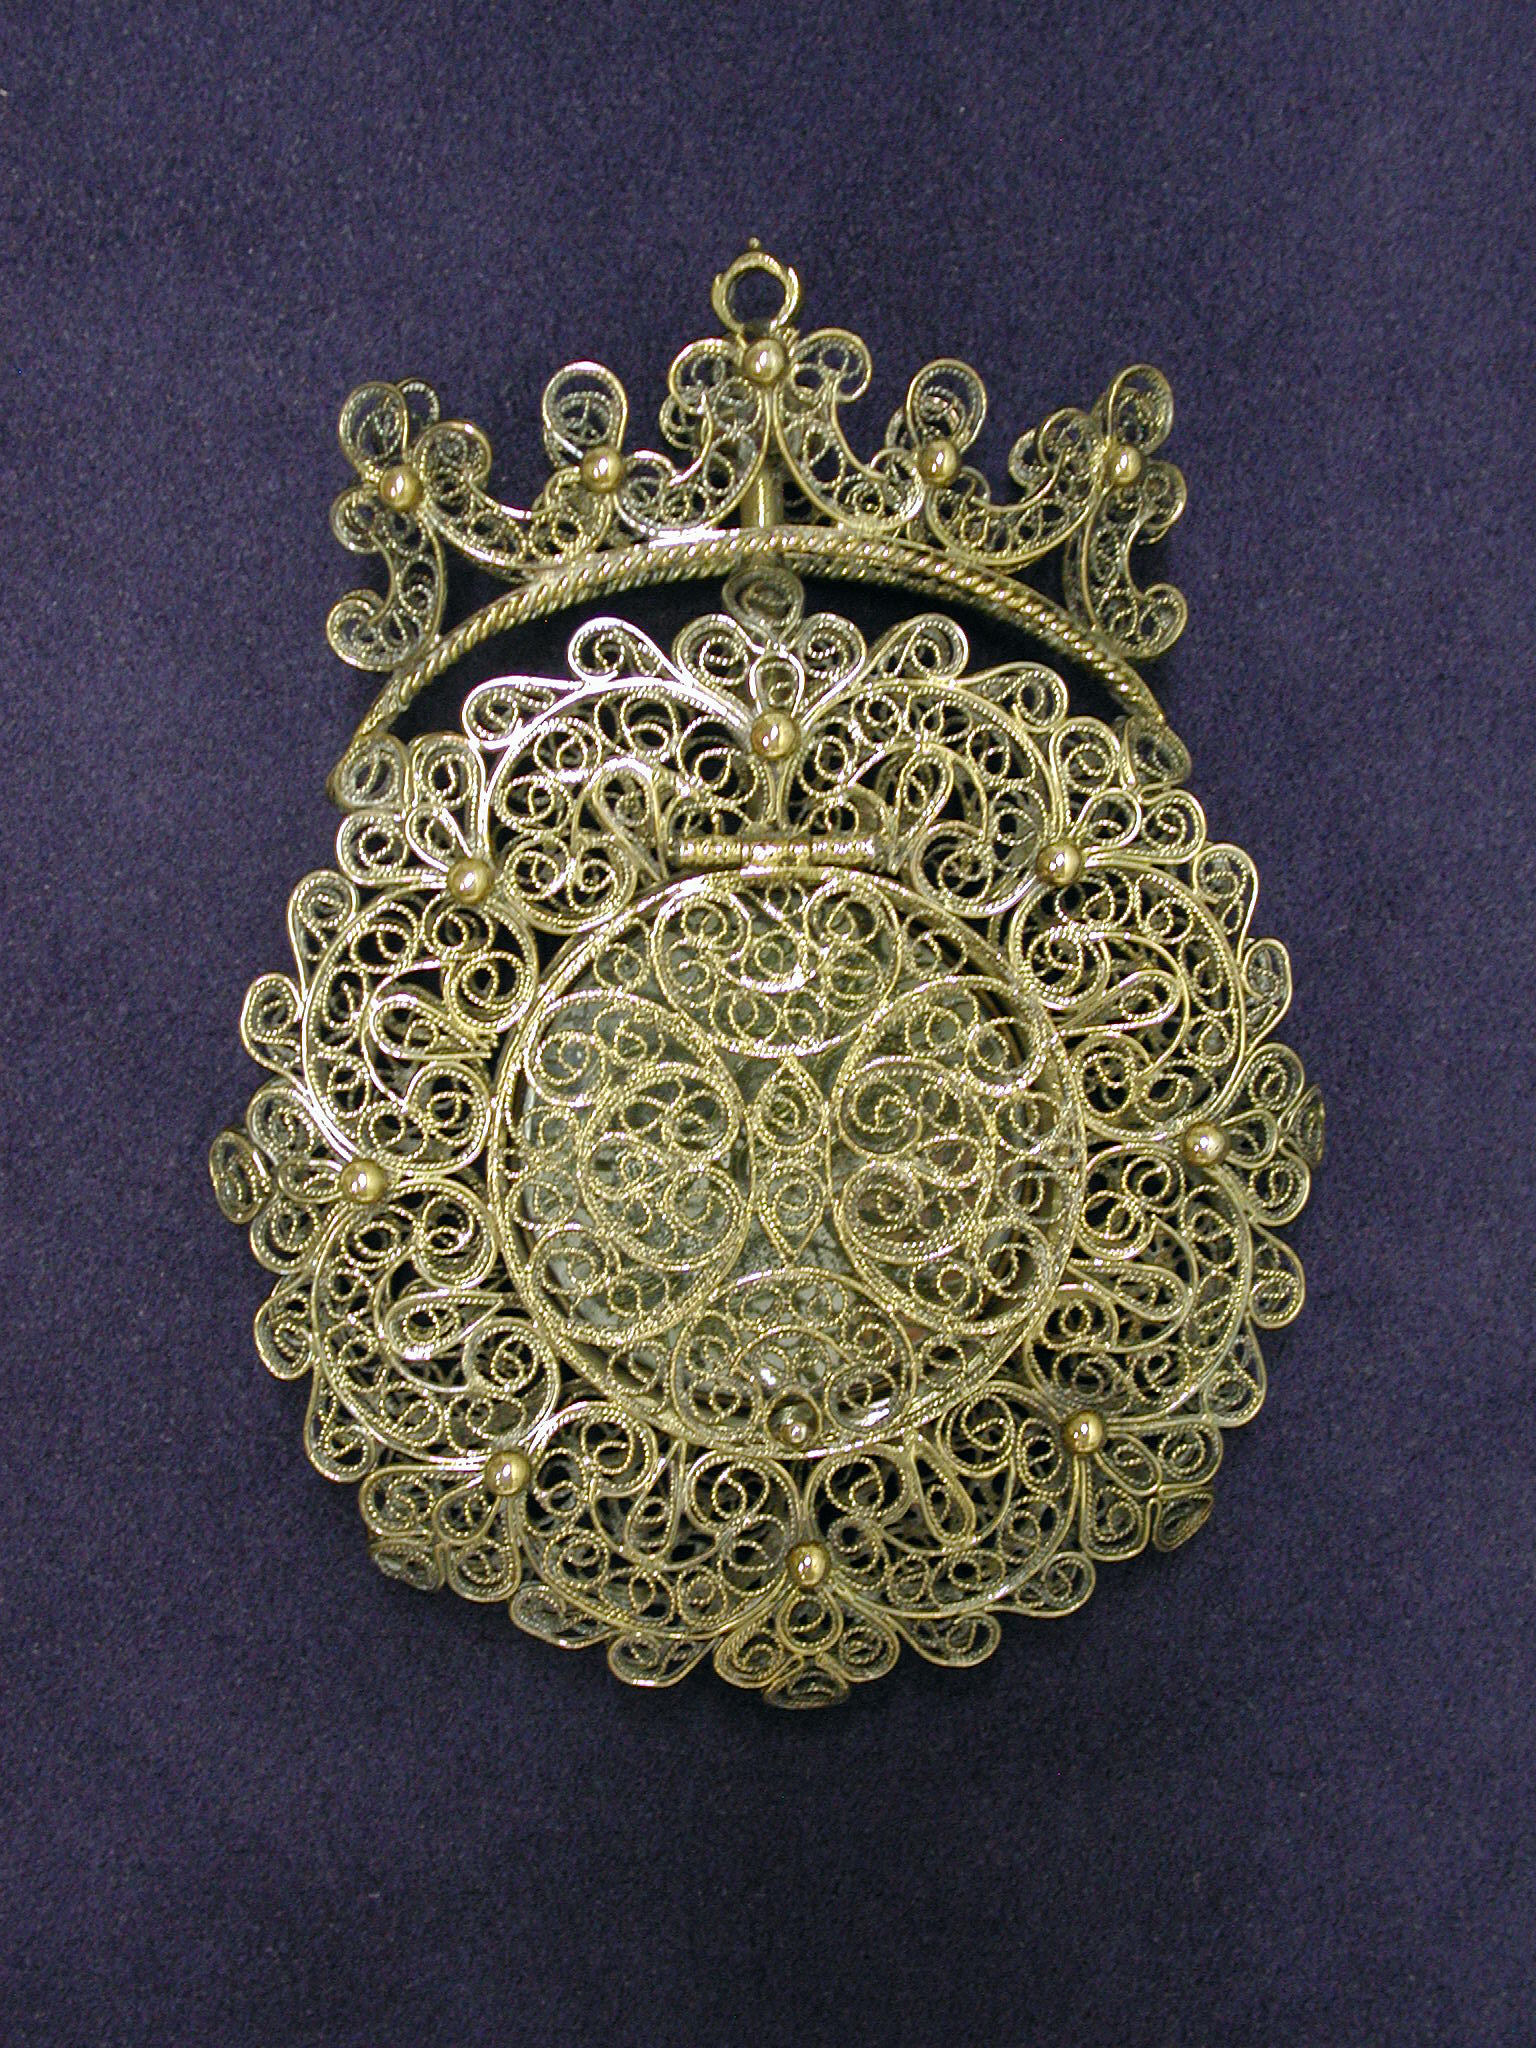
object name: mirror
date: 1601-1700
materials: copper gilt